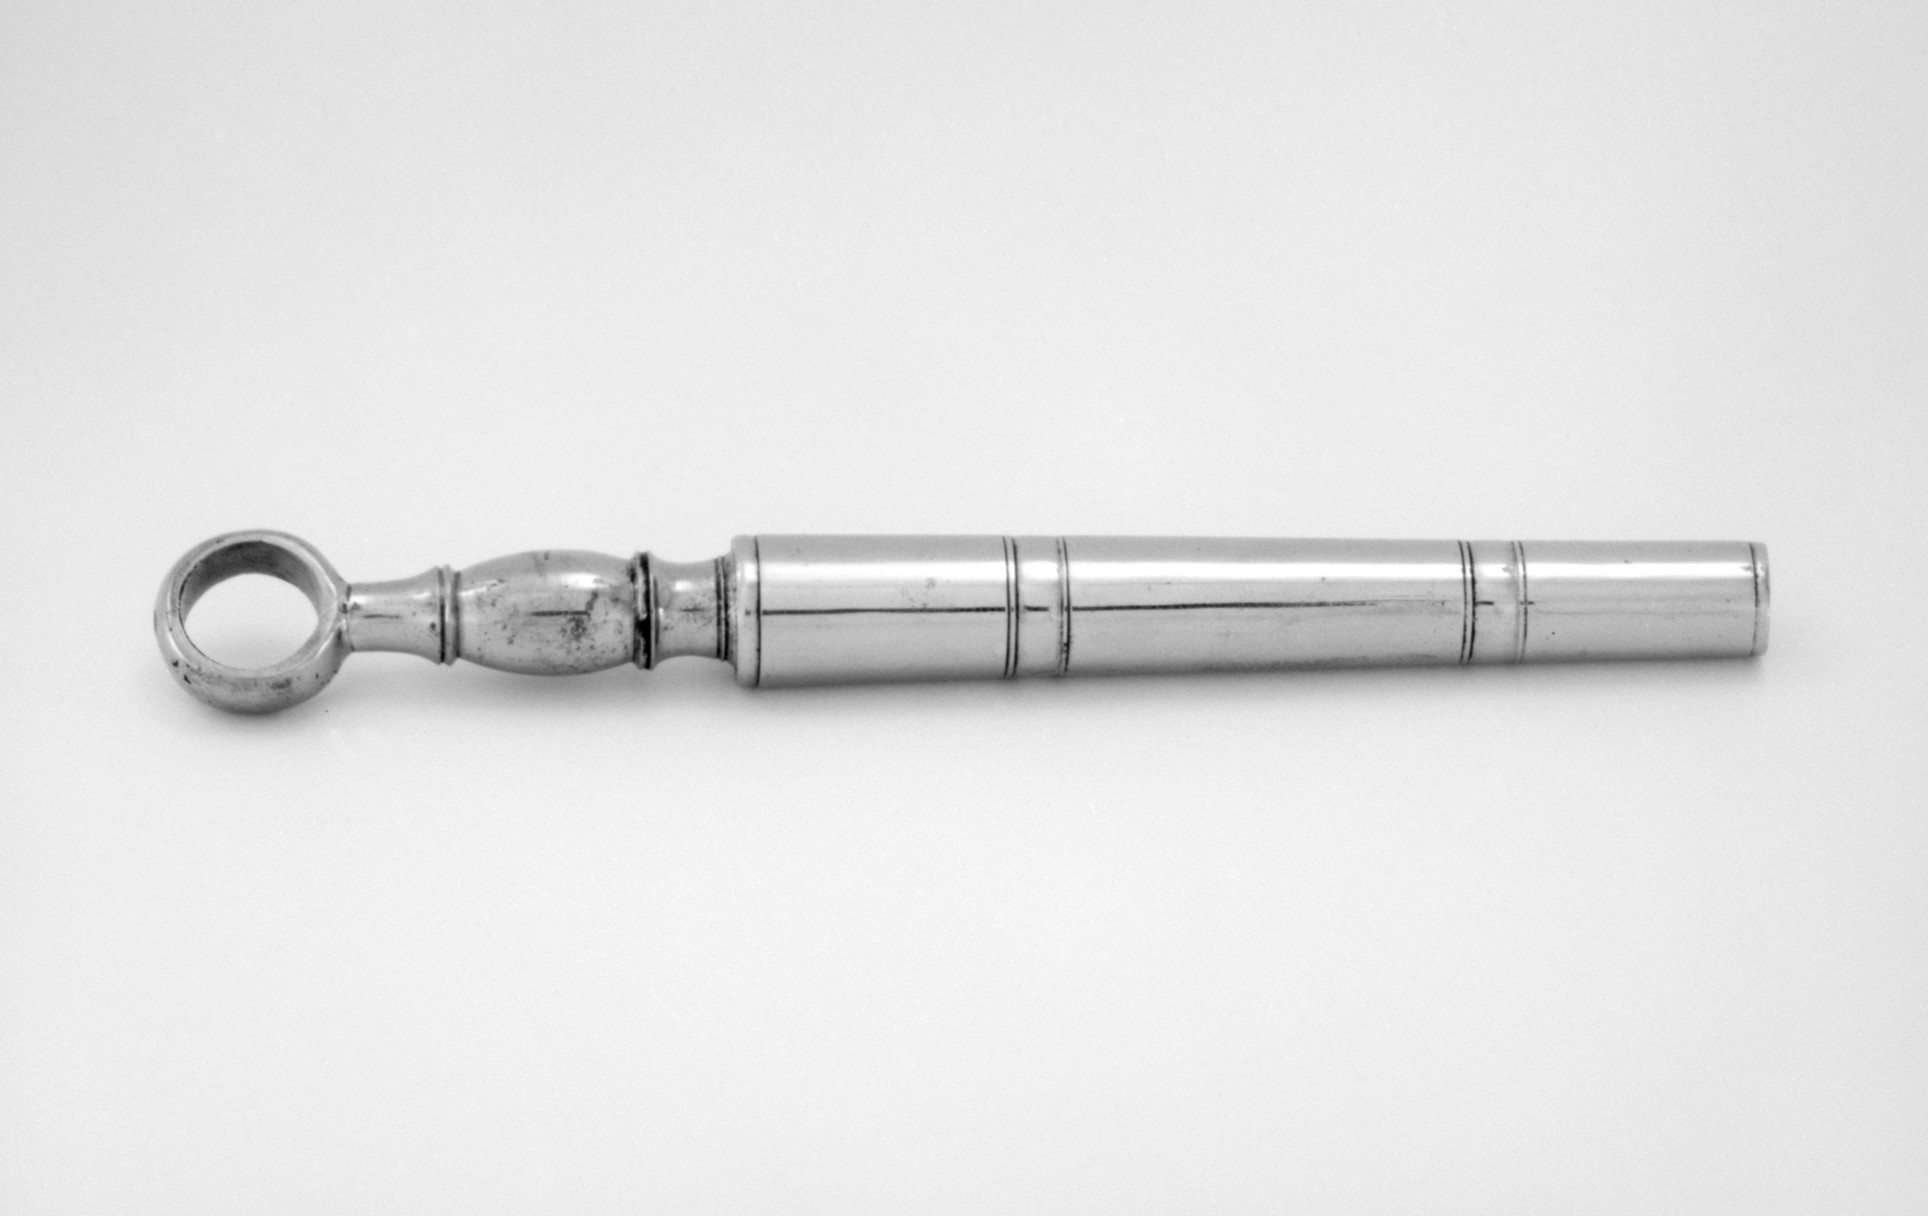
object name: corkscrew with sheath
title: Corkscrew with sheath (part of a set)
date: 1848-1849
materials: steel